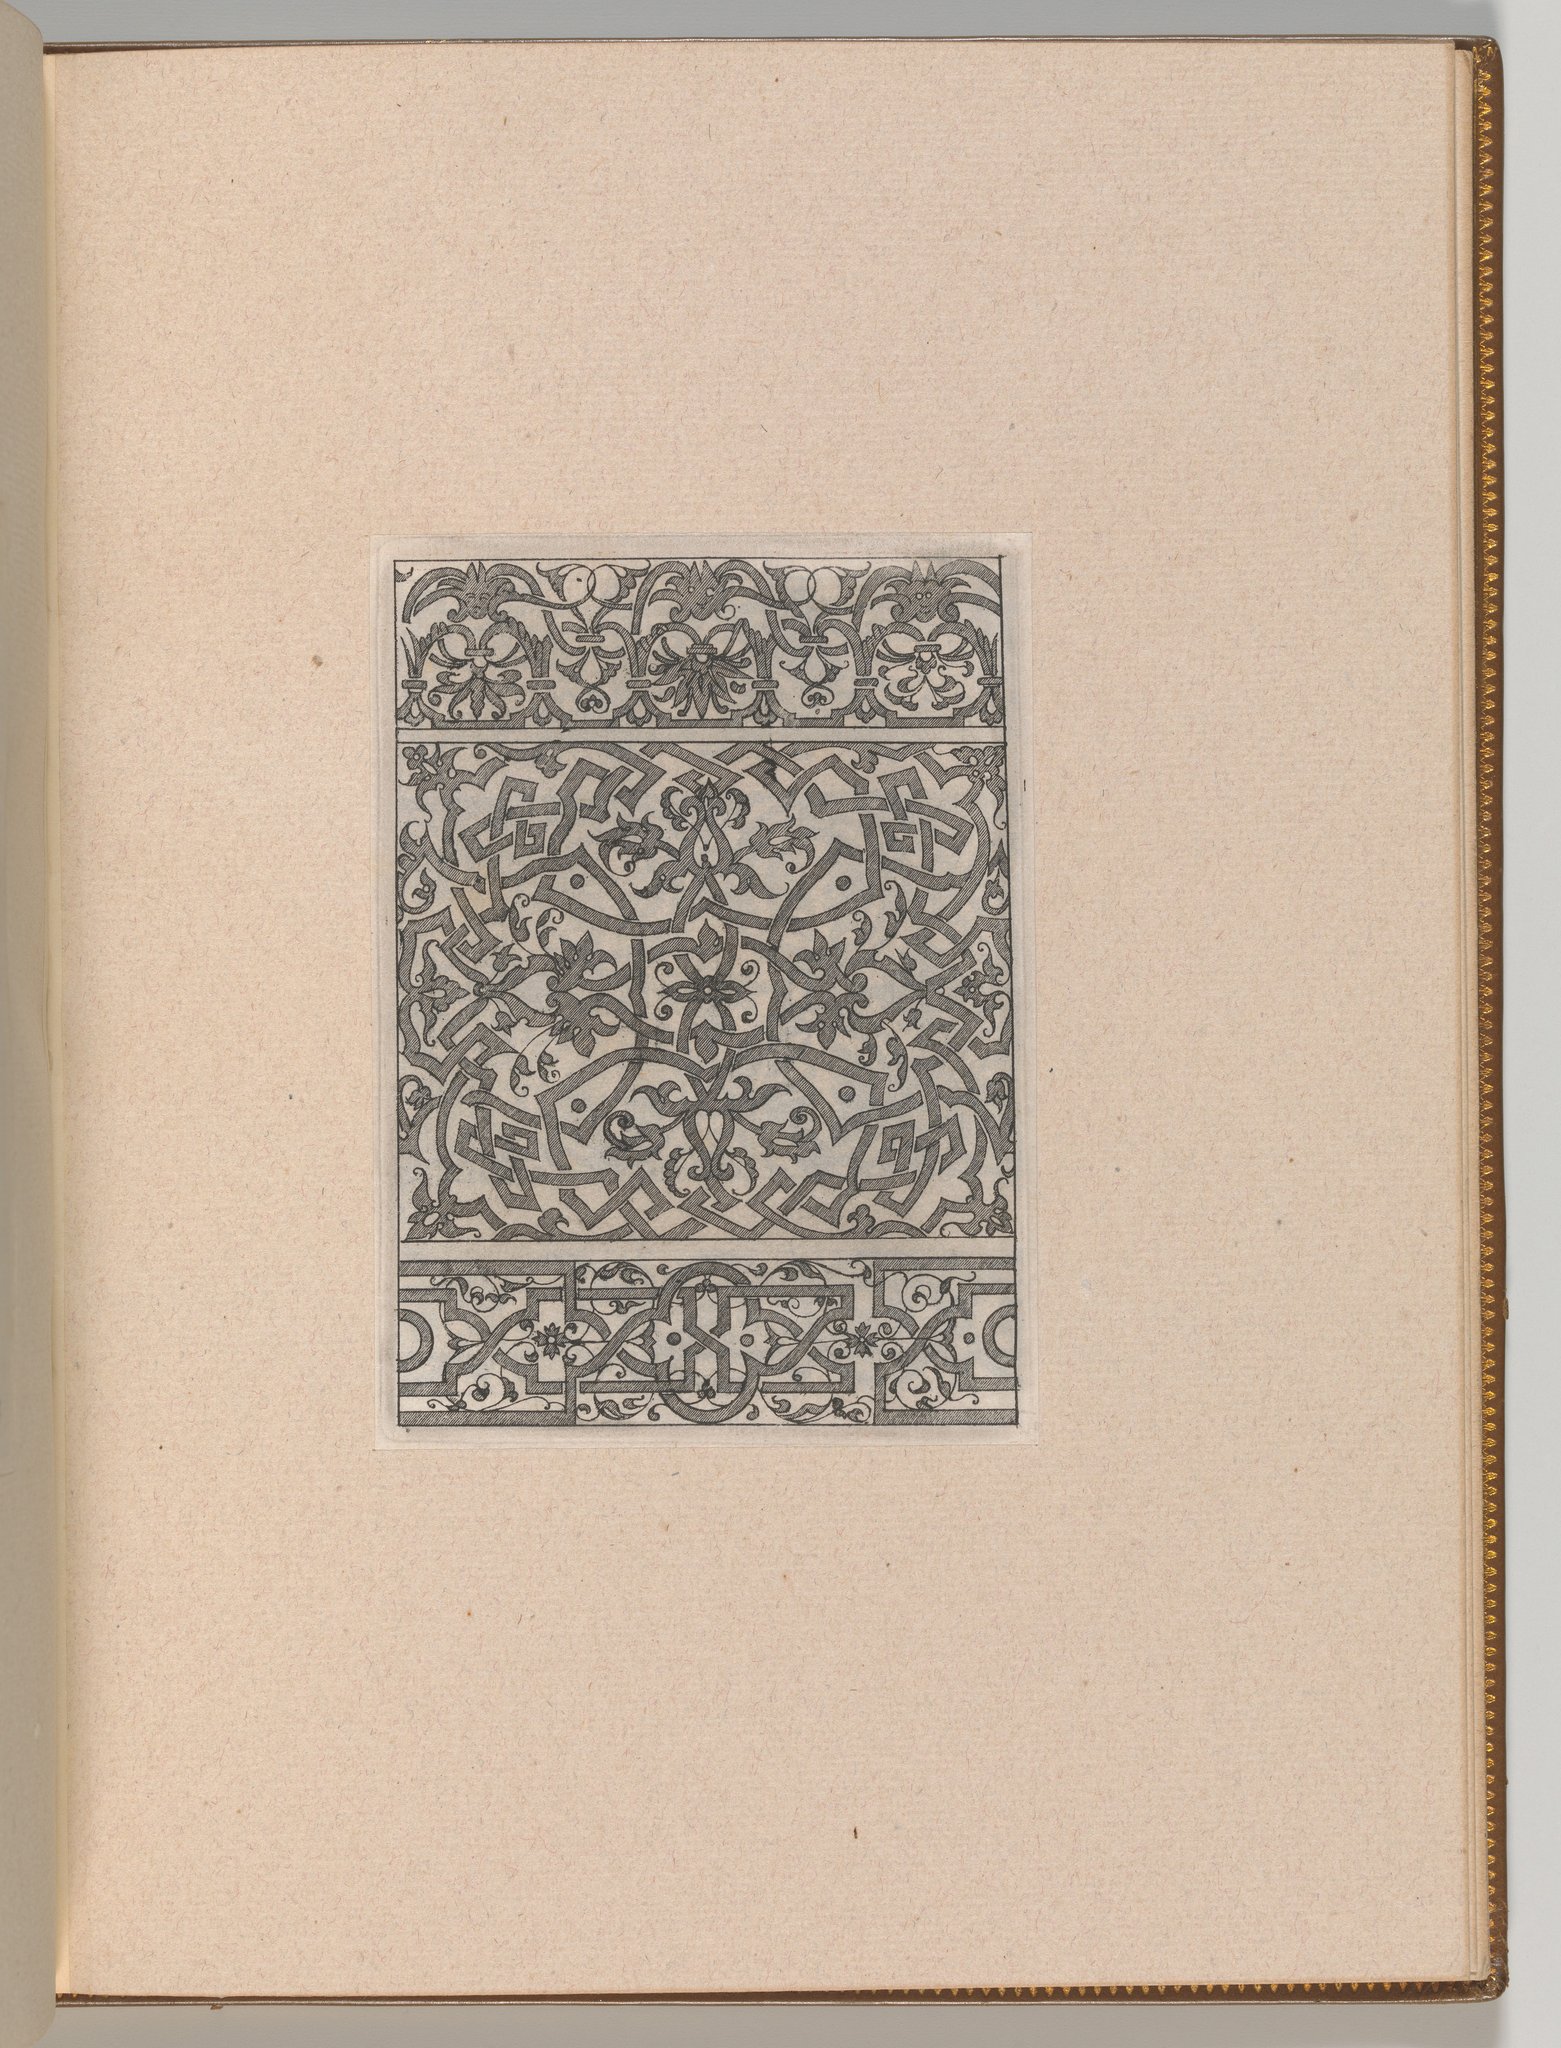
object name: album print ornament architecture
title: Copies after the 'Livre contenant passement de moresques' (plate 14)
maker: jacques androuet du cerceau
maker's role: artist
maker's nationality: french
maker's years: 1510-1585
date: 1801-1900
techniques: etching